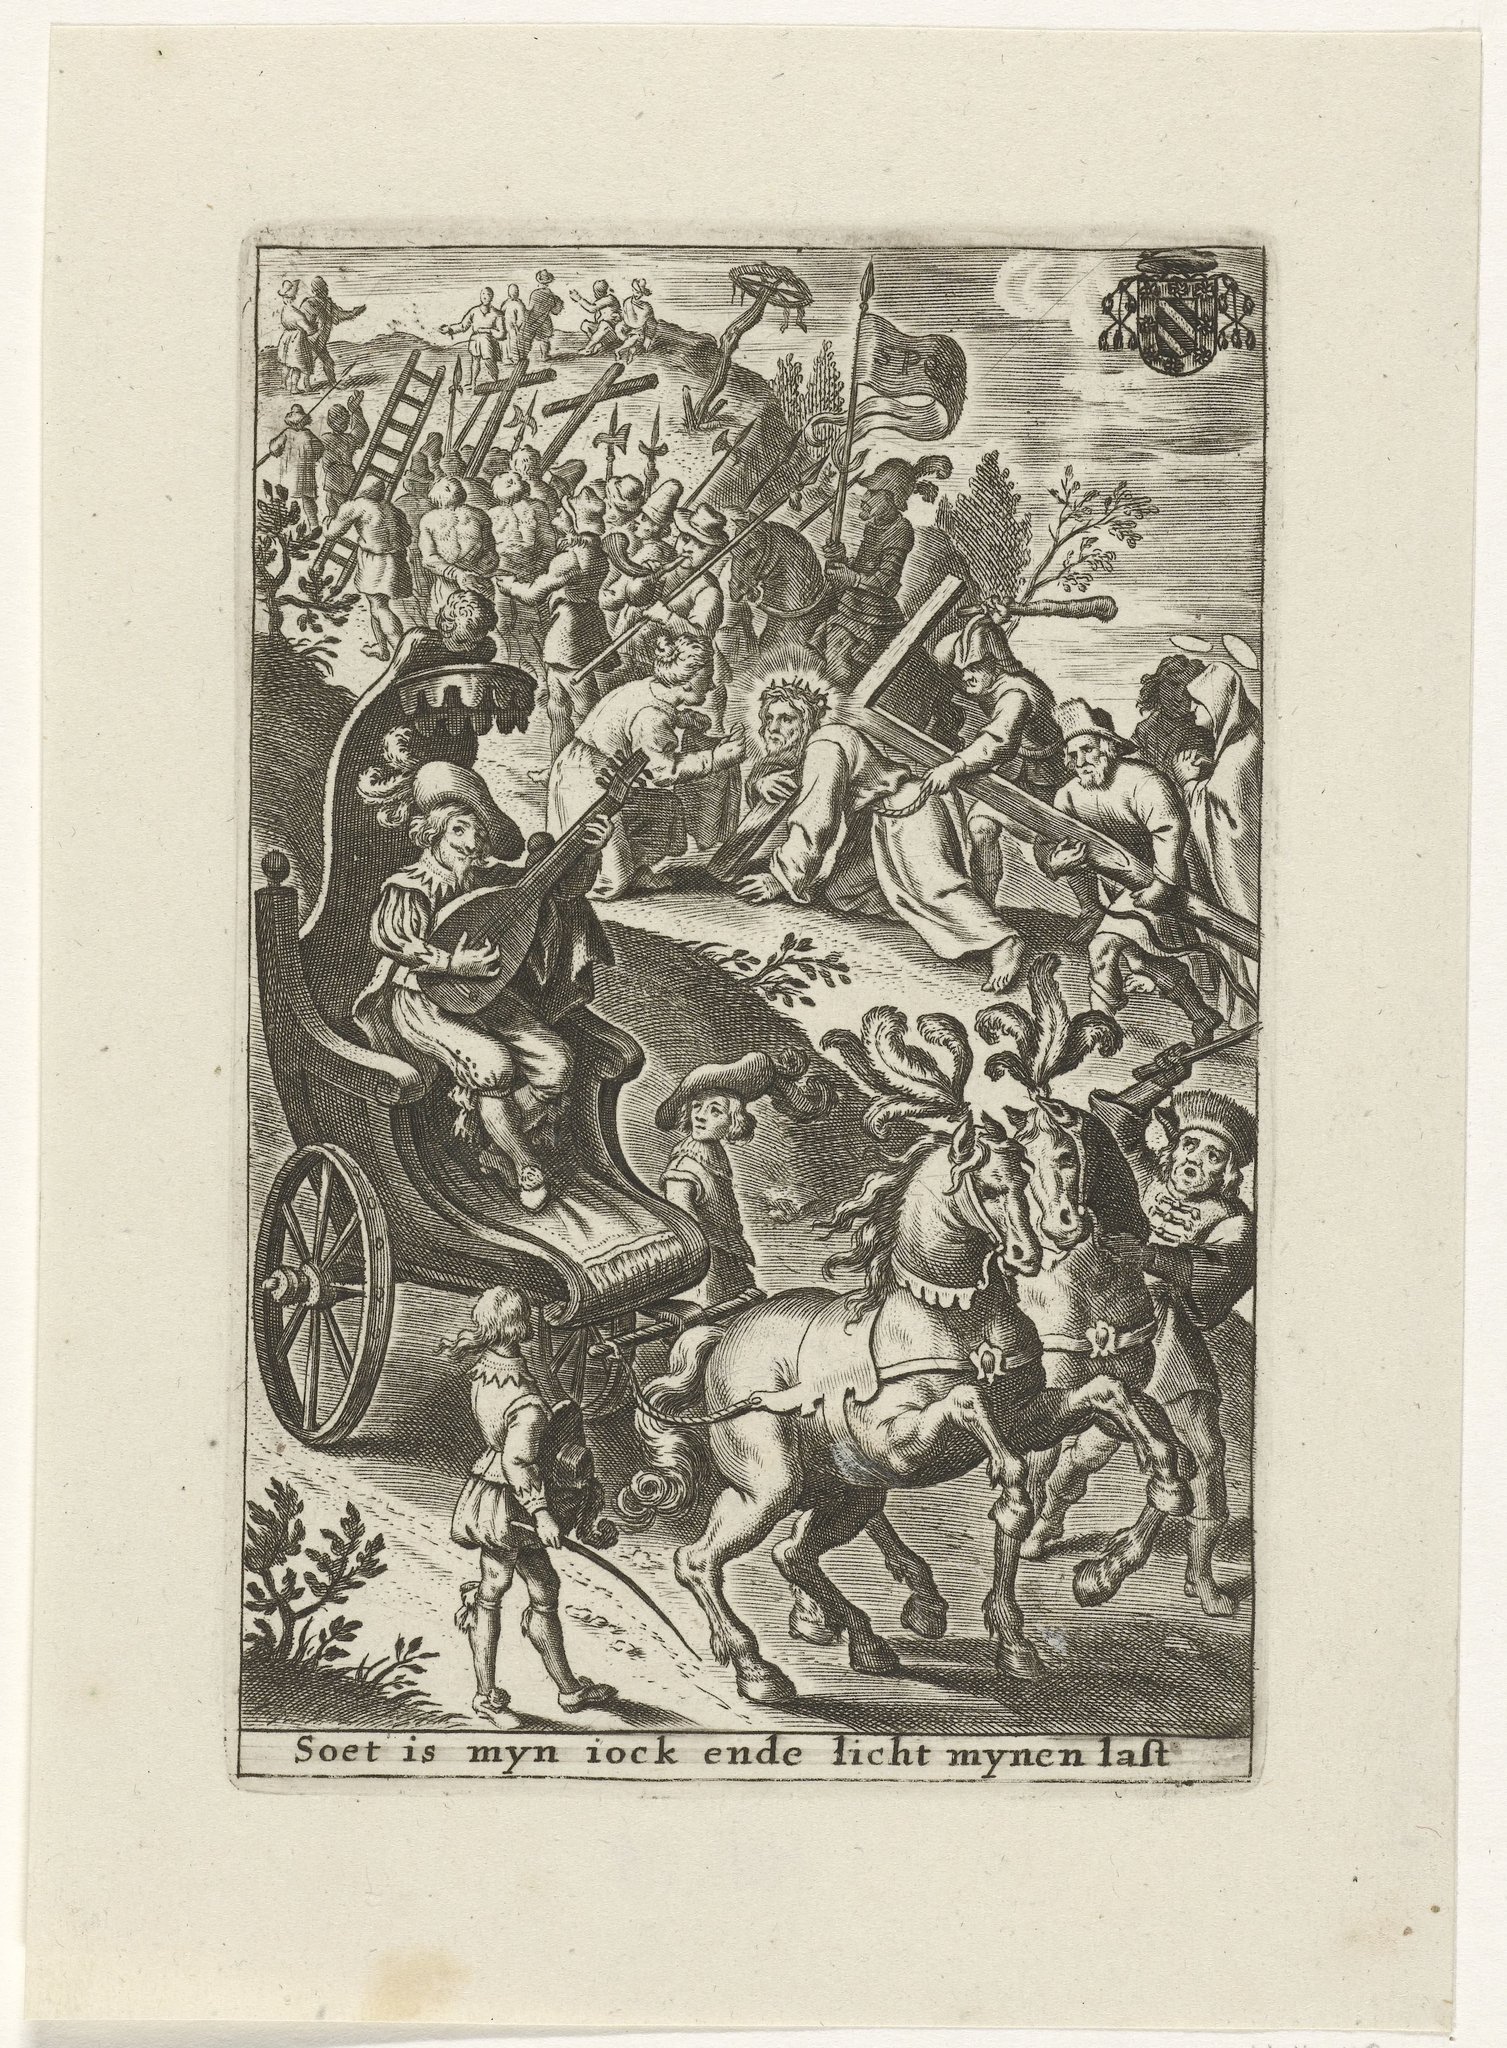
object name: print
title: Soet is myn iock ende licht mynen last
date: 1630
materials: paper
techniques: engraving, etching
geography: antwerp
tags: animal traction, animal-drawn vehicle (carriage etc.), making music; musician with instrument, christ collapsing ~ carrying of the cross, christ meets veronica, who has a cloth to wipe christ's face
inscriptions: collector's mark: Lugt 2228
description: Op de voorgrond een koets, getrokken door twee paarden, die een lichte last draagt: een musicerende hoveling. Als voorbeeld van het dragen van een zware last is daarboven afgebeeld: Christus die valt tijdens het dragen van zijn kruis naar Golgota. Simon van Cyrene helpt hem met het dragen. Veronica biedt hem een doek aan om zijn zweet af te drogen. Rechtsboven een wapenschild van een kanunnik. De prent heeft een onderschrift in het Nederlands. Prent uit een boekuitgave waarin steeds een scène uit het leven van Christus tegenover een wereldse situatie is gesteld.